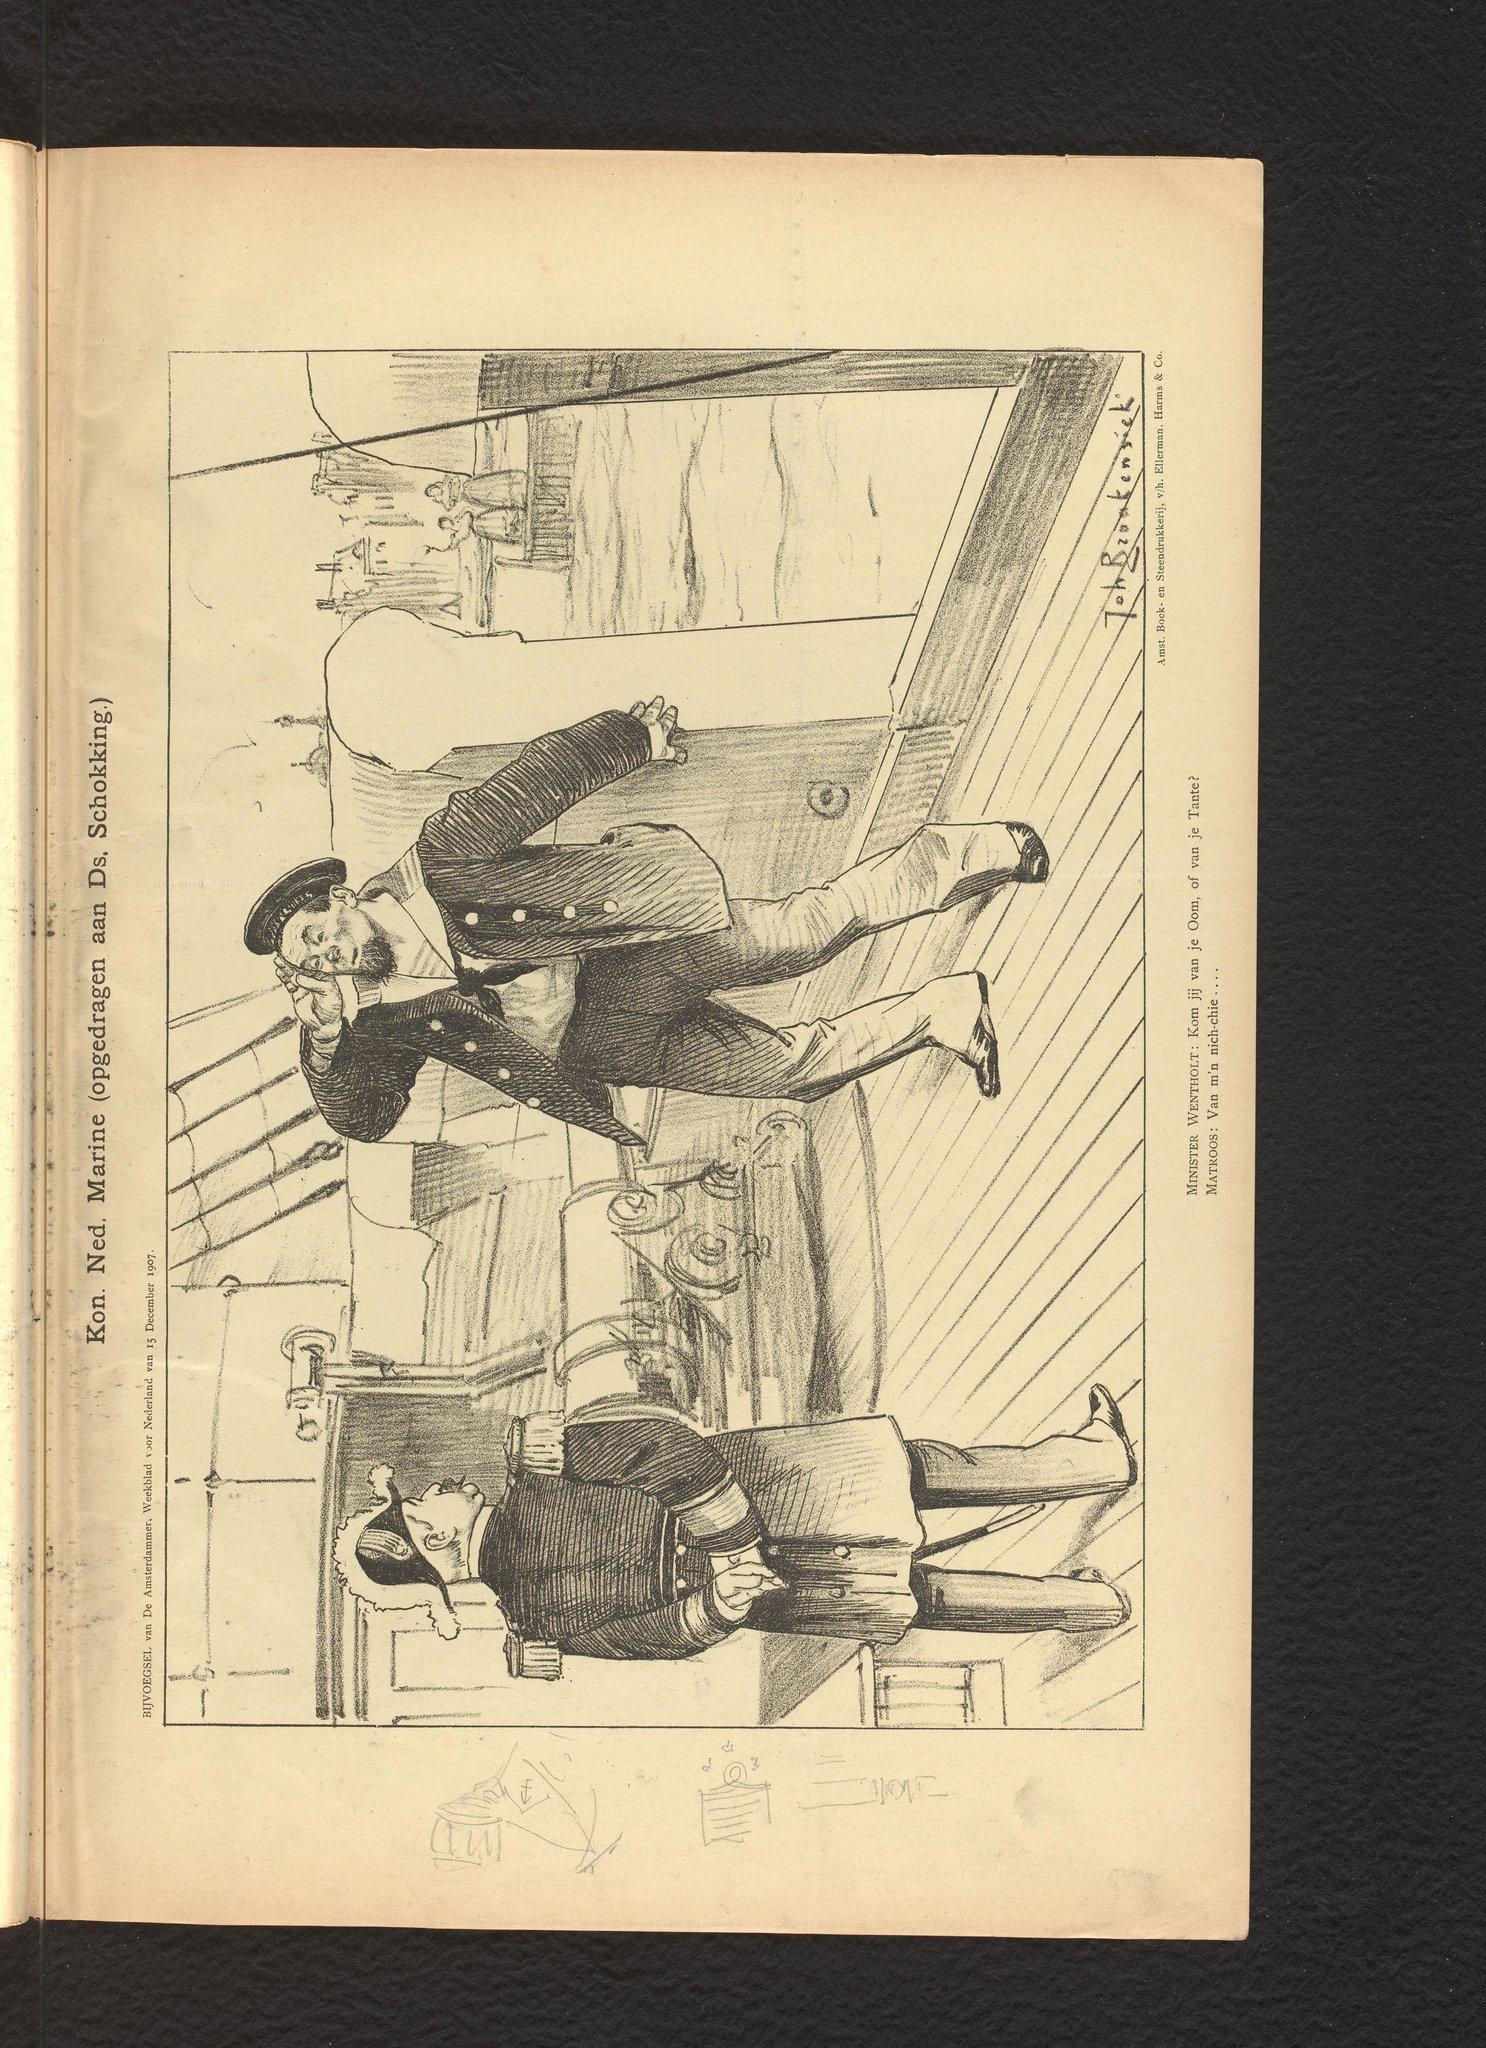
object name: cartoon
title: Kon. Ned. Marine (opgedragen aan Ds. Schokking.)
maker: johan braakensiek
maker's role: draughtsman, print maker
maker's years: 1858-1940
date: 1907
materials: paper, pencil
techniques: lithograph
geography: amsterdam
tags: parts of ship's exterior: deck, drunkenness, political caricatures and satires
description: Minister van Marine Jan Wentholt ondervraagt aan dek een dronken matroos die van verlof terugkeert. De prent is opgedragen aan dominee en Tweede Kamerlid Jan Schokking. In de marge enige krabbels in potlood.